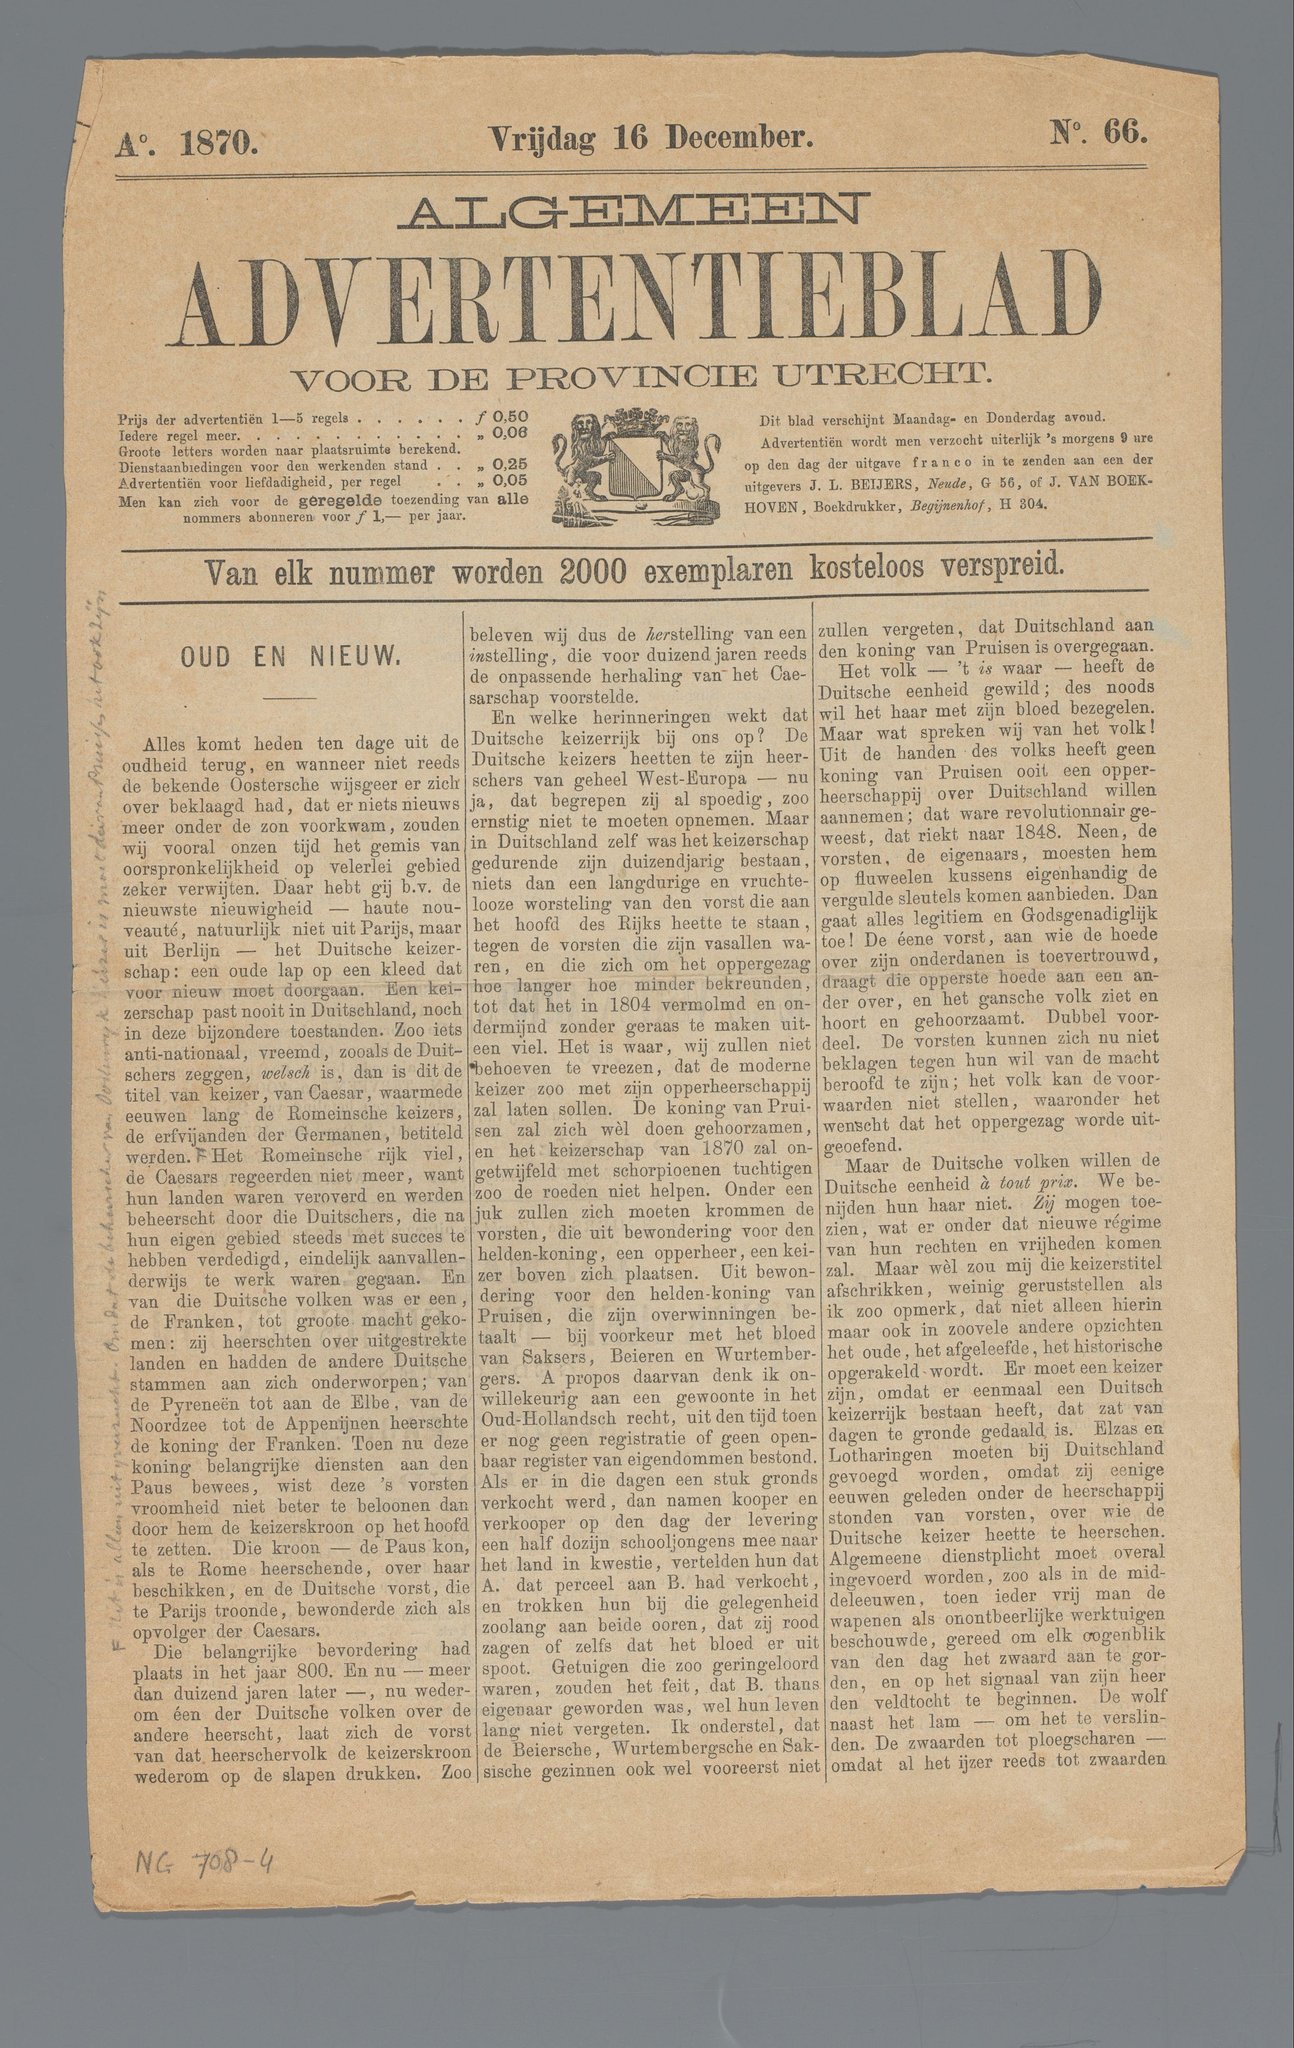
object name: newspaper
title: Algemeen Advertentieblad voor de provincie Utrecht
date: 1870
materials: paper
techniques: printing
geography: utrecht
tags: netherlands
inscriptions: date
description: 2 pp, Ao. 1870, nr. 66. Gemerkt; r.b.: stempel: 'Te / Zegelen'. Gedateerd.